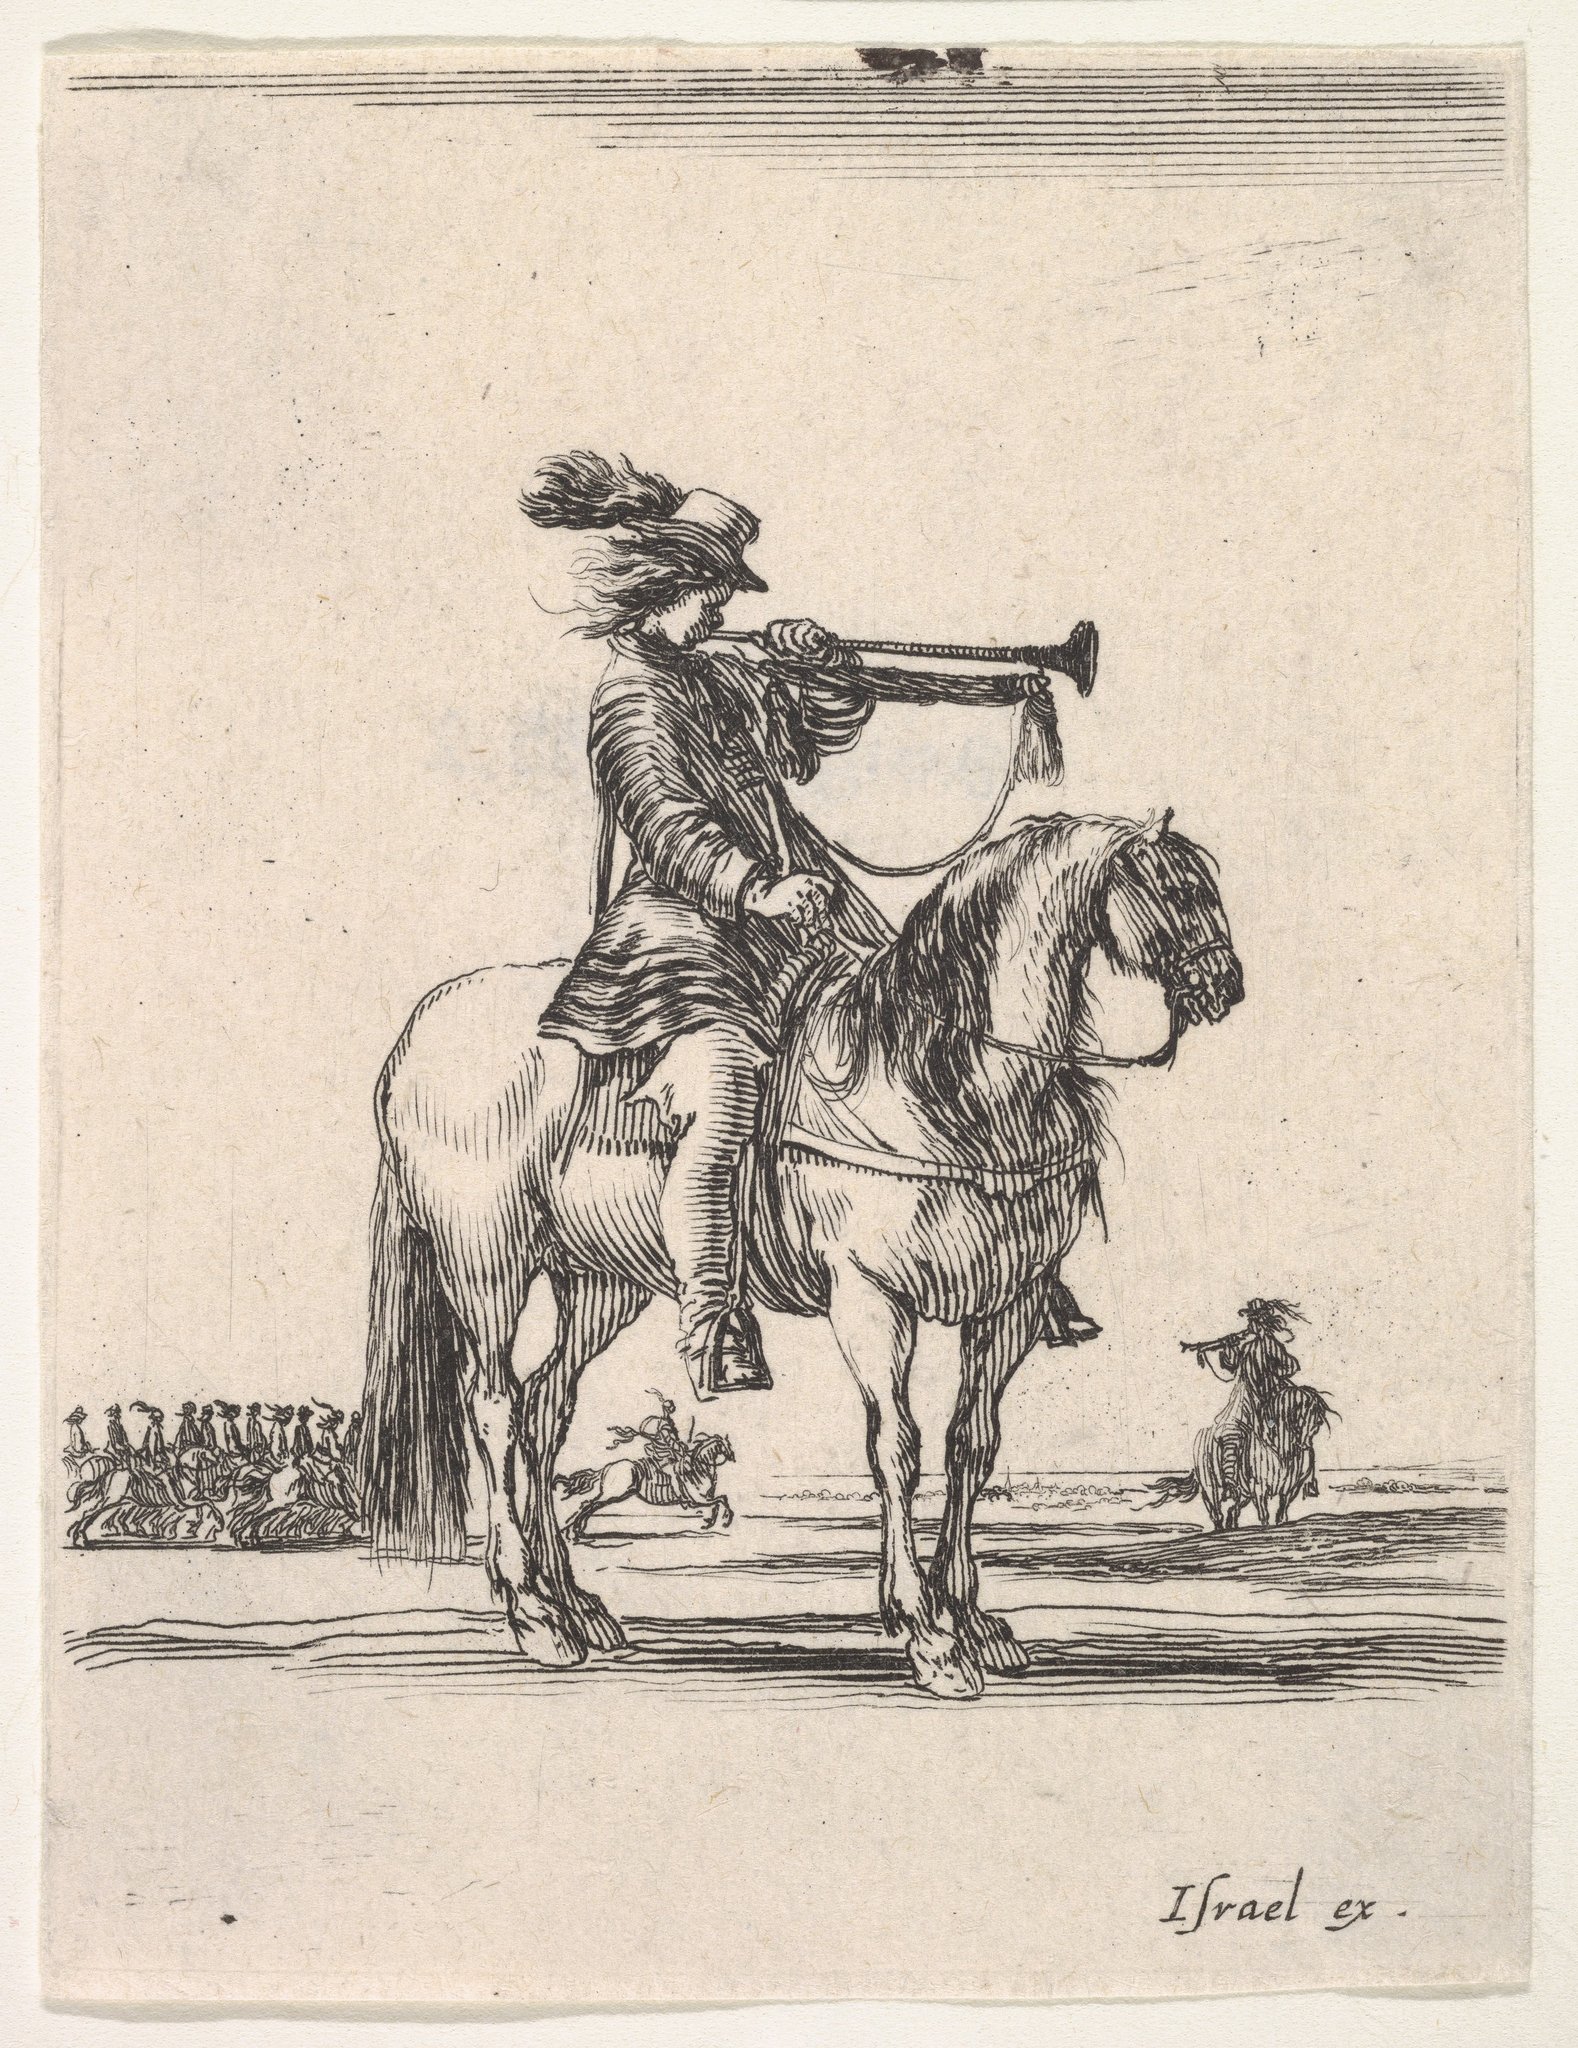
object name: print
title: Trumpeter on horseback facing right, a group of horsemen in the background, from "Various cavalry exercises" (Diverses exercices de cavalerie)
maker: stefano della bella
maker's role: artist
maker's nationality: italian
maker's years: 1610-1664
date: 1642-1645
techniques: etching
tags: men,trumpets,horses